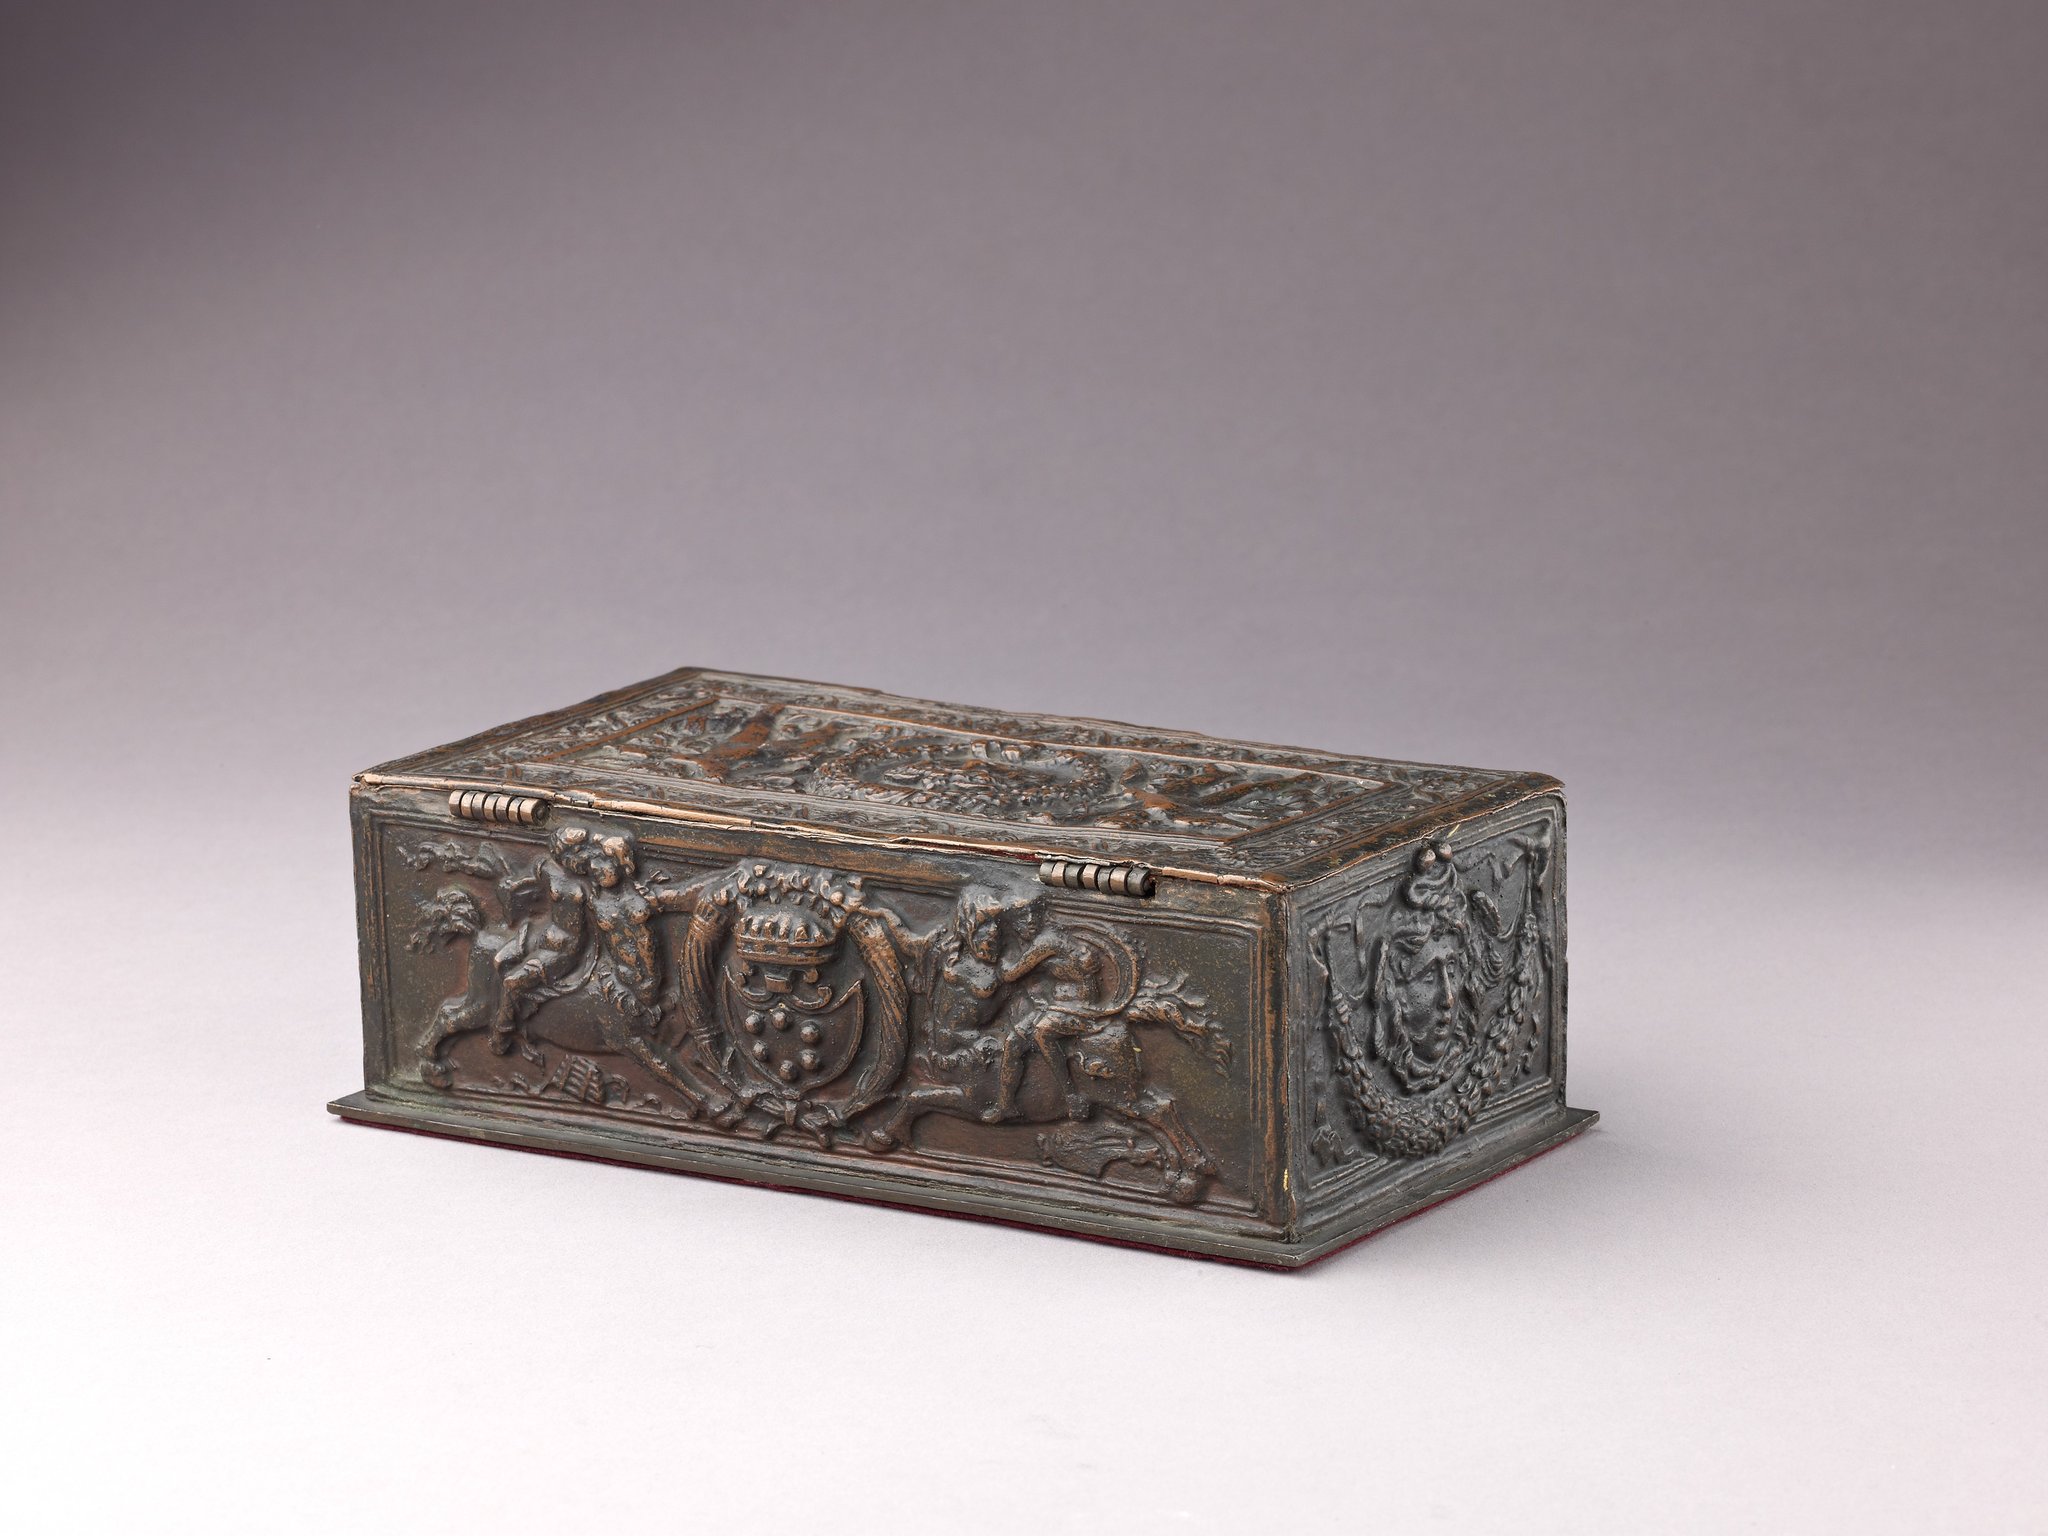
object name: writing box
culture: italian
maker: italian (manifattura di signa, florence?)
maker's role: artist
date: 1900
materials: copper alloy, patina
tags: centaurs,coat of arms